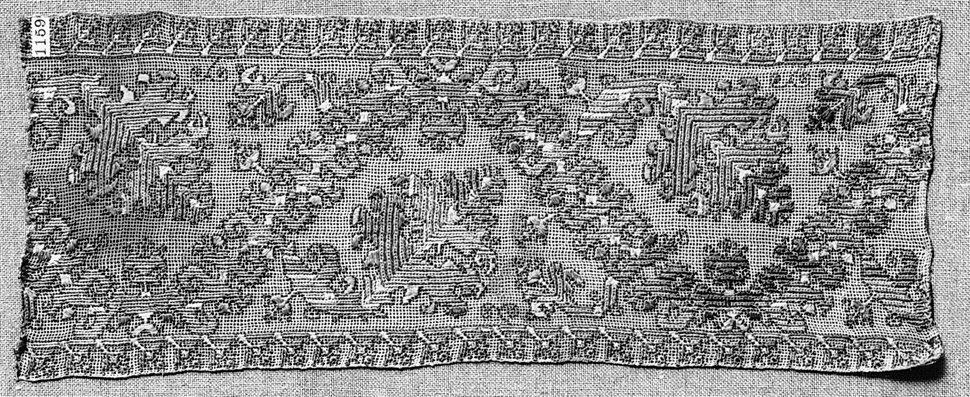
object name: fragment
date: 1601-1700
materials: lace